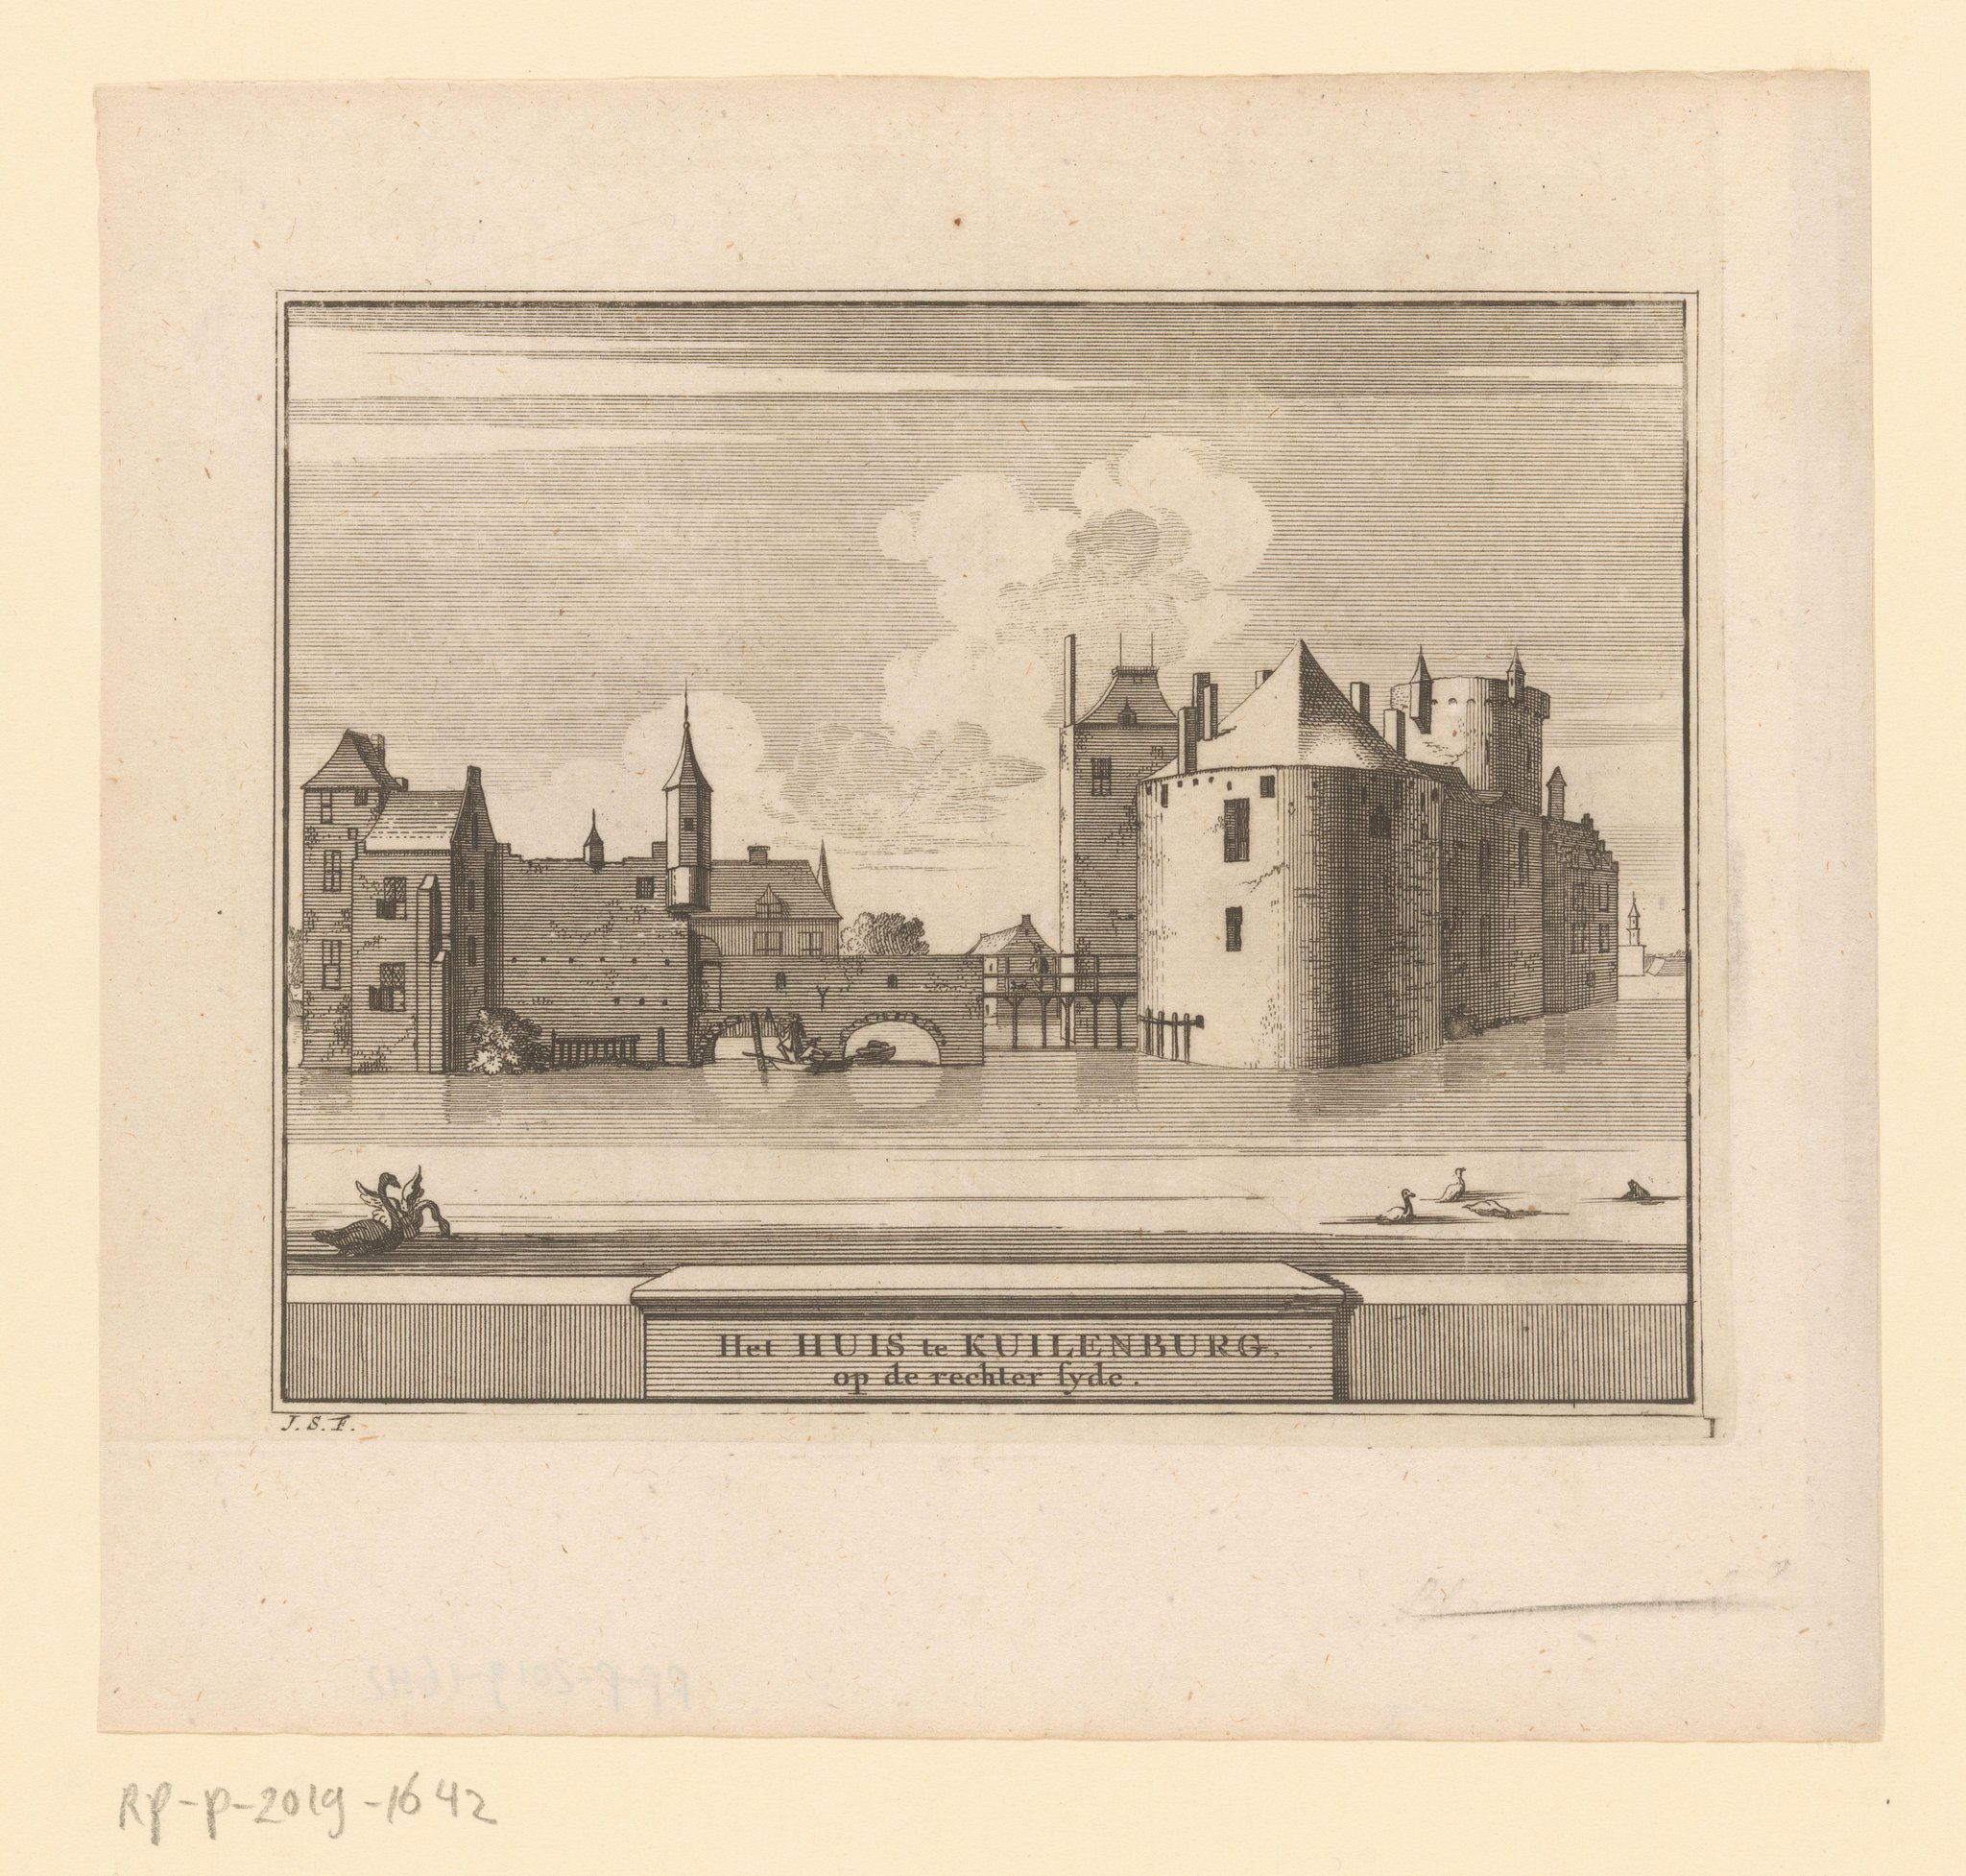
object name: book illustration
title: Gezicht op Kasteel Culemborg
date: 1711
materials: paper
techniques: etching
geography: amsterdam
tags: castle, water-birds: swan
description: Prent voor het eerst gebruikt in: Smids, Ludolph. Schatkamer der Nederlandsse oudheden; of Woordenboek, behelsende Nederlands steden. Amsterdam: Pieter de Coup, 1711, tussen p. 190 en 191. Verscheen daarna mogelijk in heruitgaven van dit werk in 1737 en 1774. In 1721 verscheen er een uitgave met alleen de prenten: Nederlandsche oudheden, bestaande in zestig verbeeldingen (...) gelegen in Holland, 't Sticht van Utrecht en Gelderland enz. Amsterdam: Hendrik Bosch, 1721.